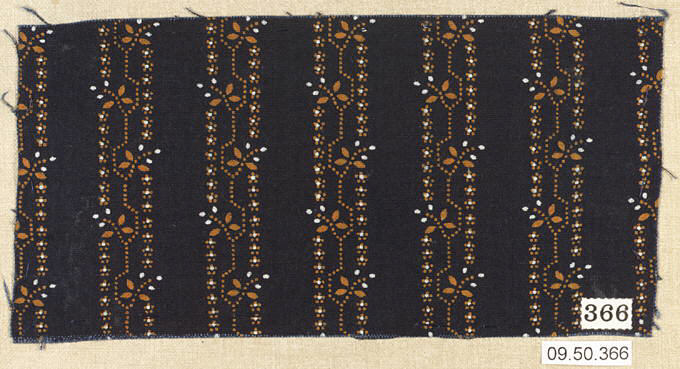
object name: piece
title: Piece (one of 116)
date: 1801-1900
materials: cotton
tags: leaves